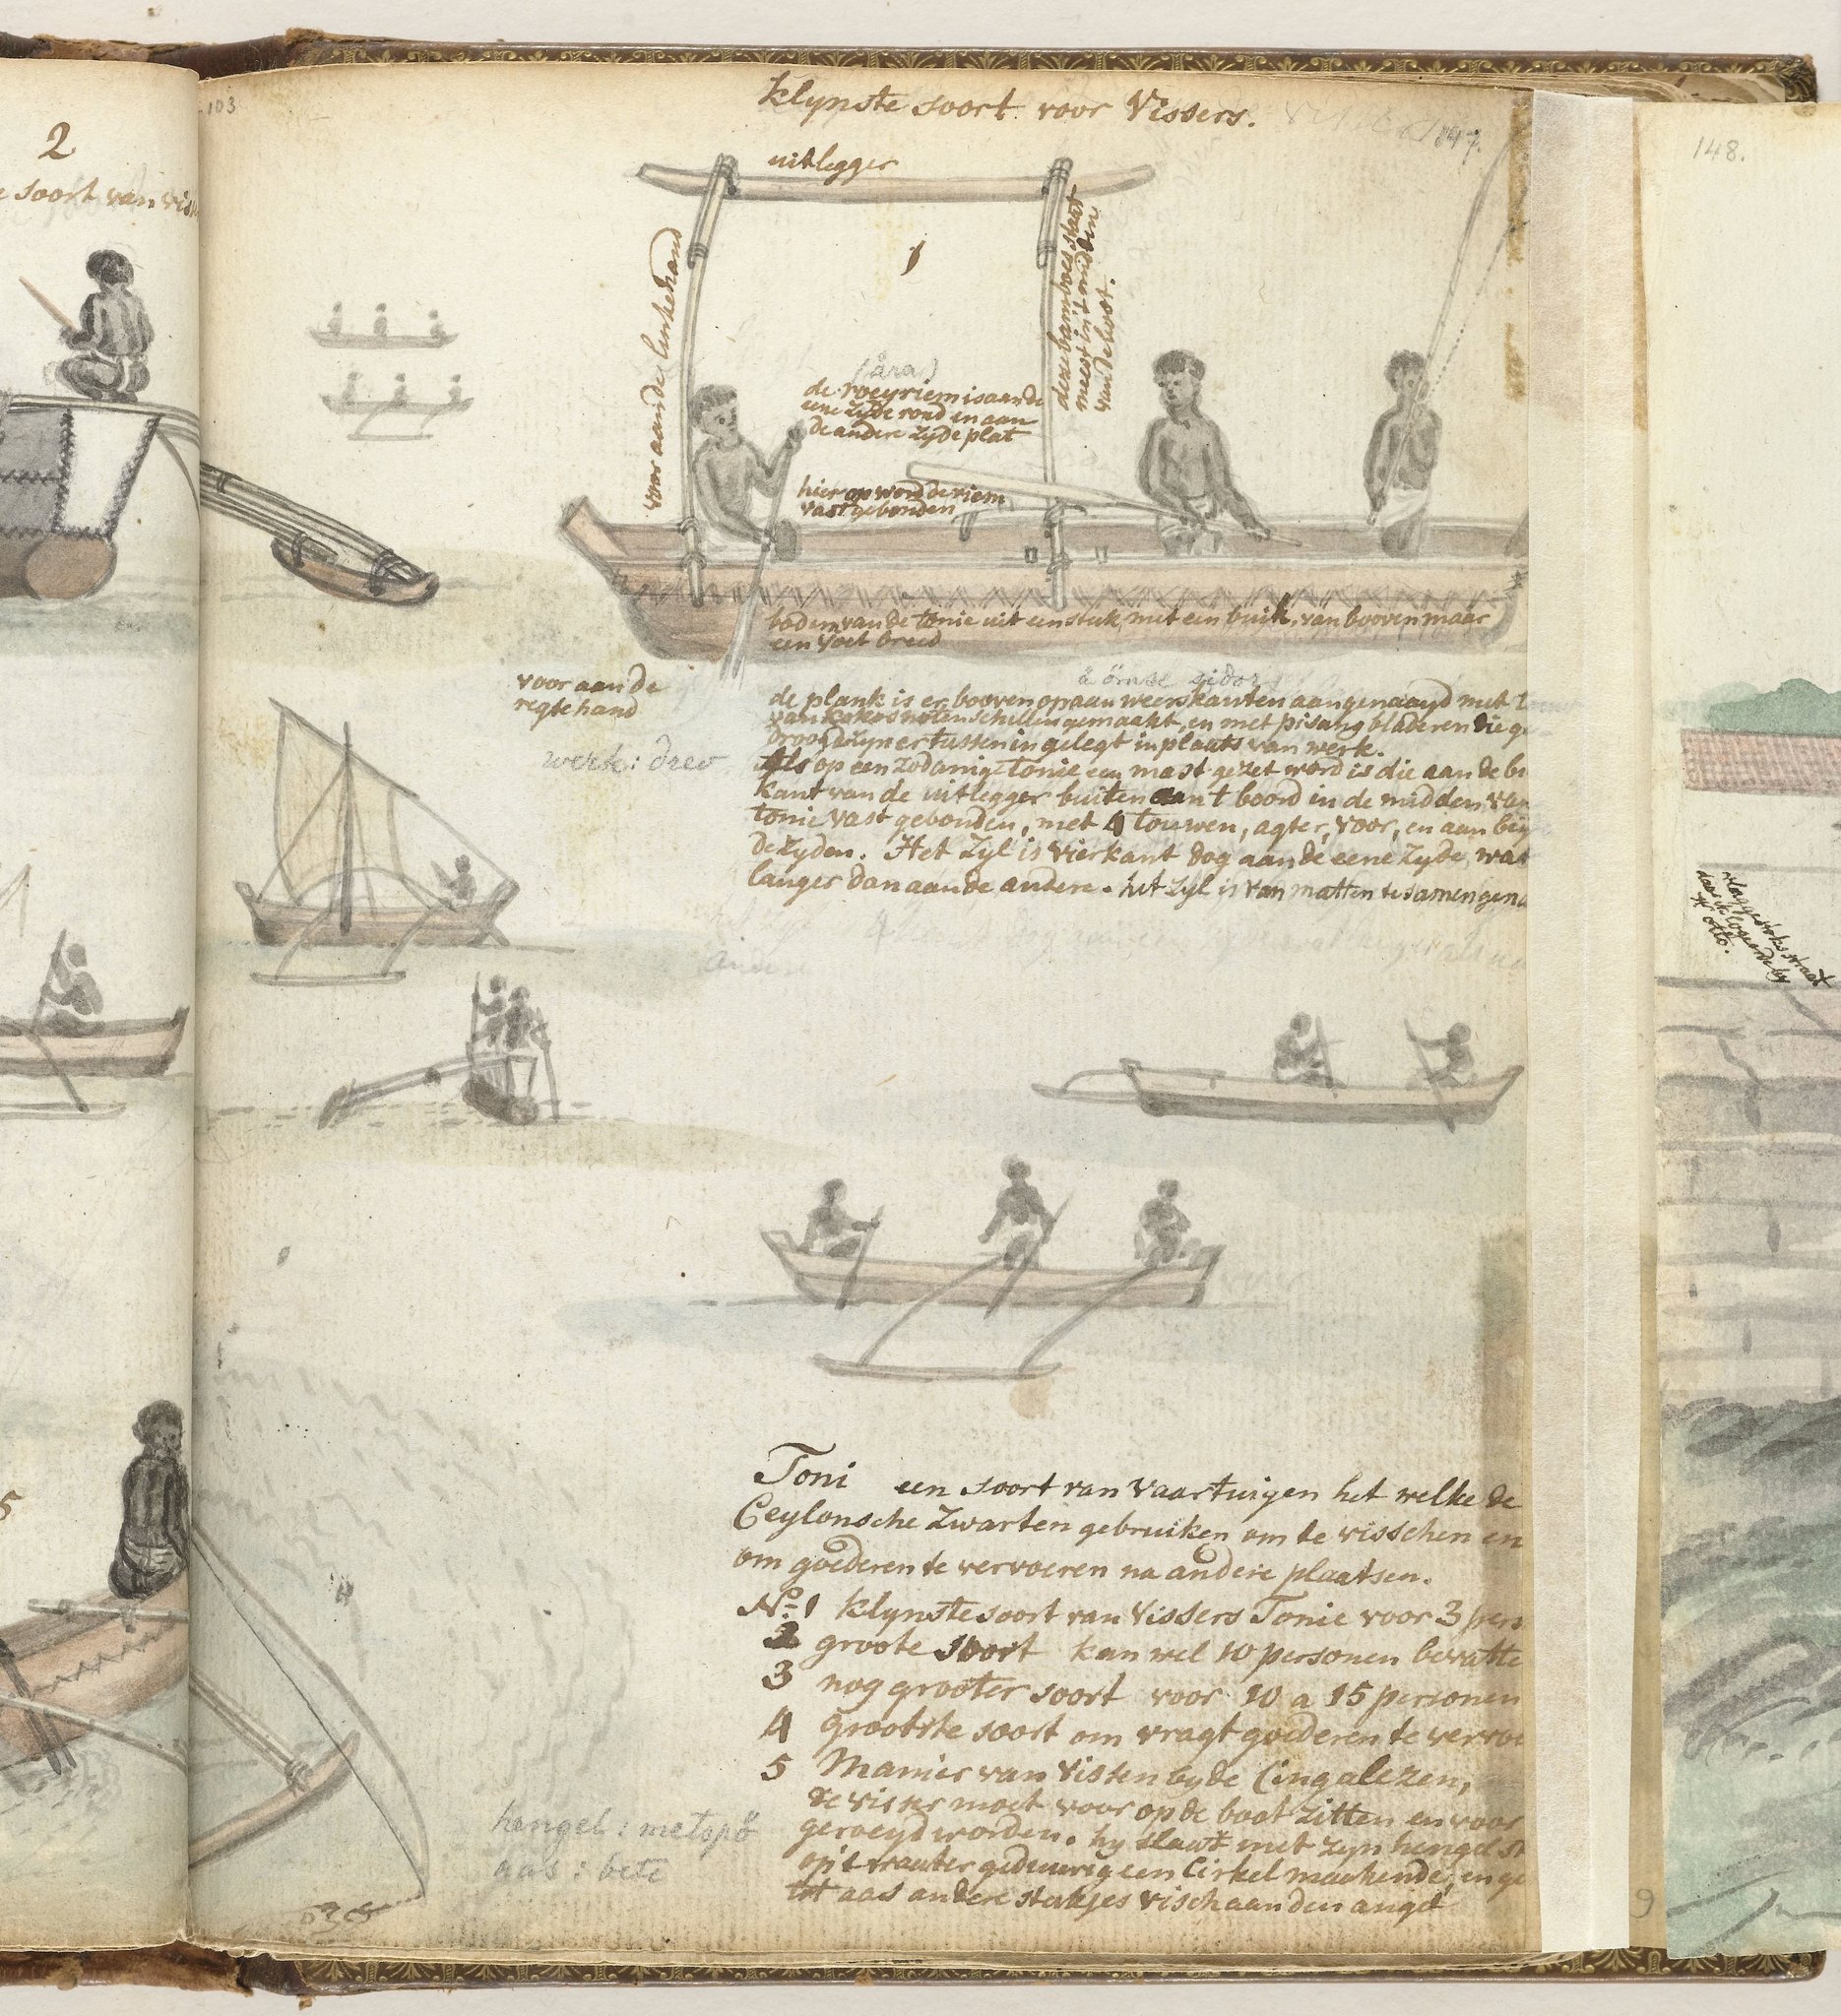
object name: drawing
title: Thonies, vissersboten in de baai van Galle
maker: jan brandes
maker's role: draughtsman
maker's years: 1743-1808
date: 1786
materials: paper, pencil, watercolor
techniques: brush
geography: galle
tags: sailing-ship, sailing-boat, rowing-boat, canoe, etc., sea and coastal fishery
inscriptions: inscription: ‘Tonies geteekend te Gale op Ceylon op den 20 January 1786’, inscription: ‘Toni een soort van vaartuigen het welke de Ceylonsche Zwarten gebruiken om te visschen en om goederen te vervoeren na andere plaatsen’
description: Kleurtekening over twee pagina's van de verschillende soorten vissersboten die de inwoners van Ceylon gebruiken. Met diverse opschriften. Onderdeel uit het schetsboek van Jan Brandes, dl. 2 (1808), p. 146-147.